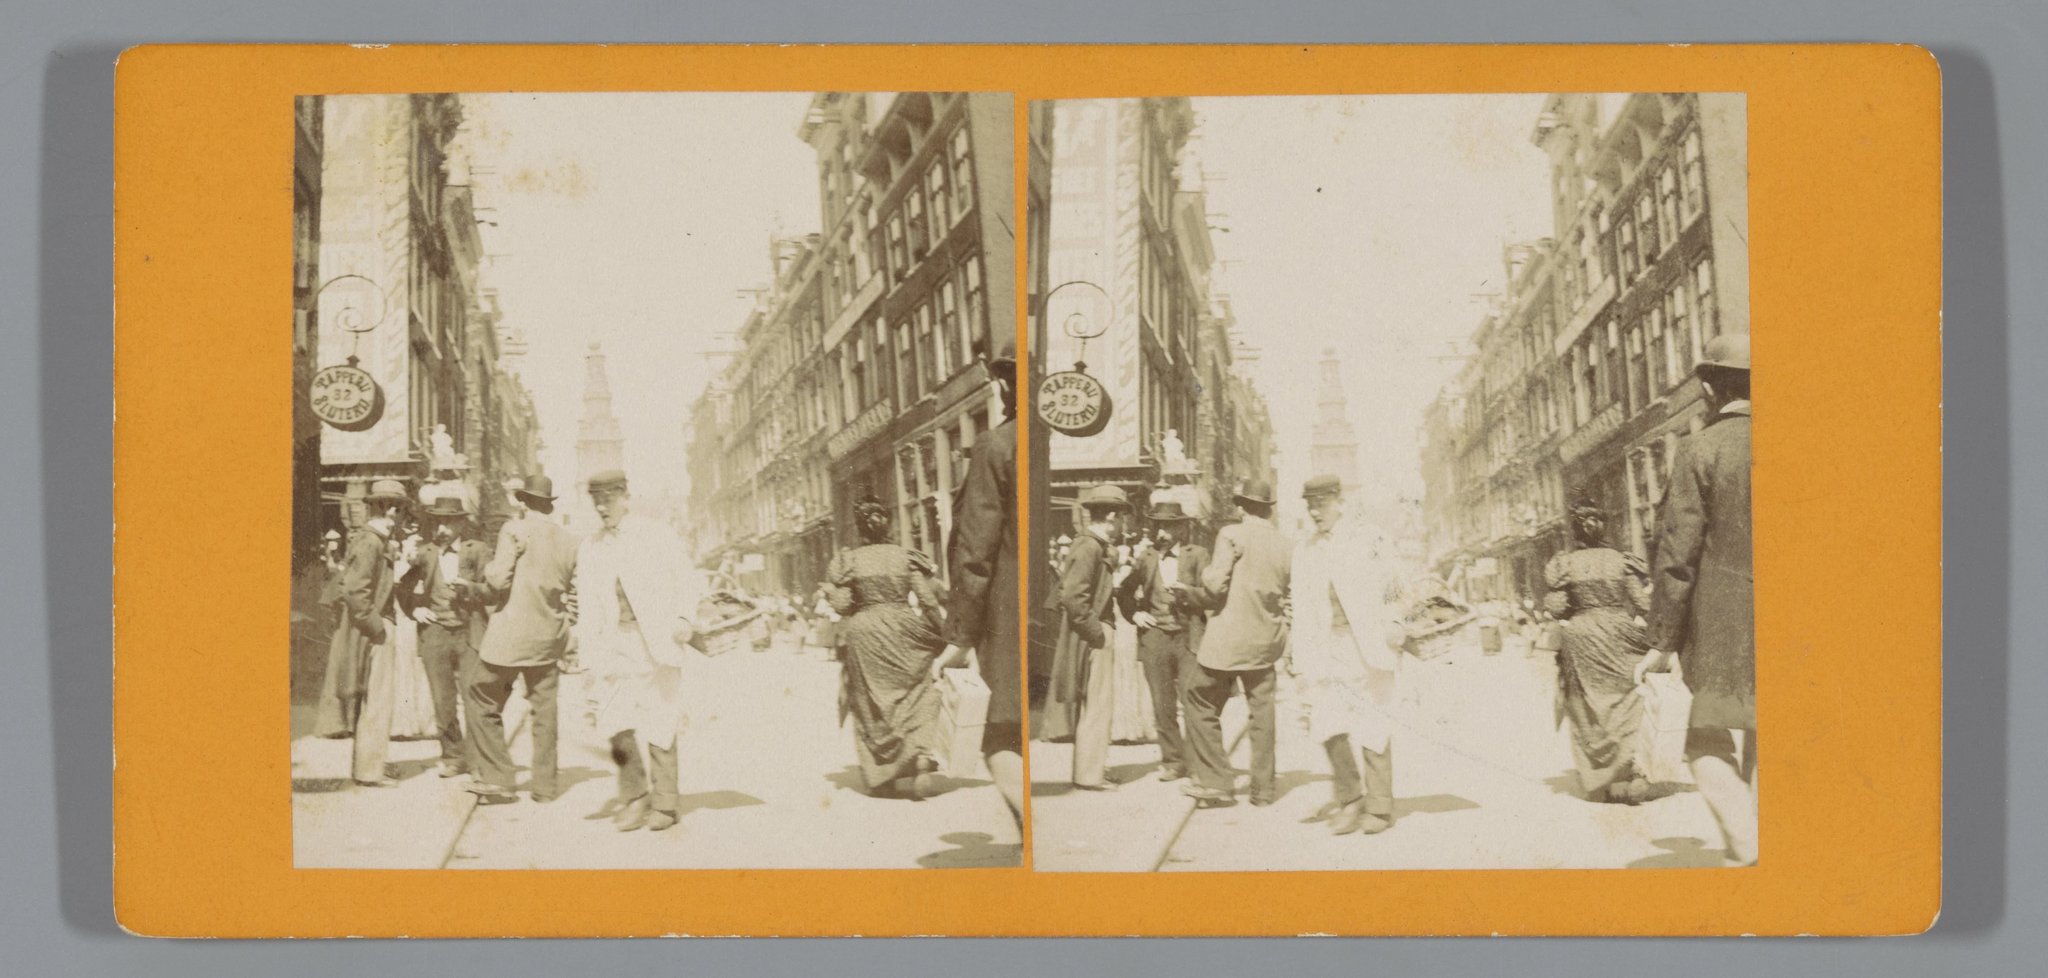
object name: stereograph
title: Jodenbreestraat in Amsterdam, gezien vanaf de Tapperij en Slijterij van L.A. Reens op nummer 32, richting de Zuiderkerk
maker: Anonymous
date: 1868-1890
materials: cardboard, paper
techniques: albumen print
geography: amsterdam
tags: street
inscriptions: inscription: ‘Amsterdam/ Jodenbreestraat’, number: ‘35’